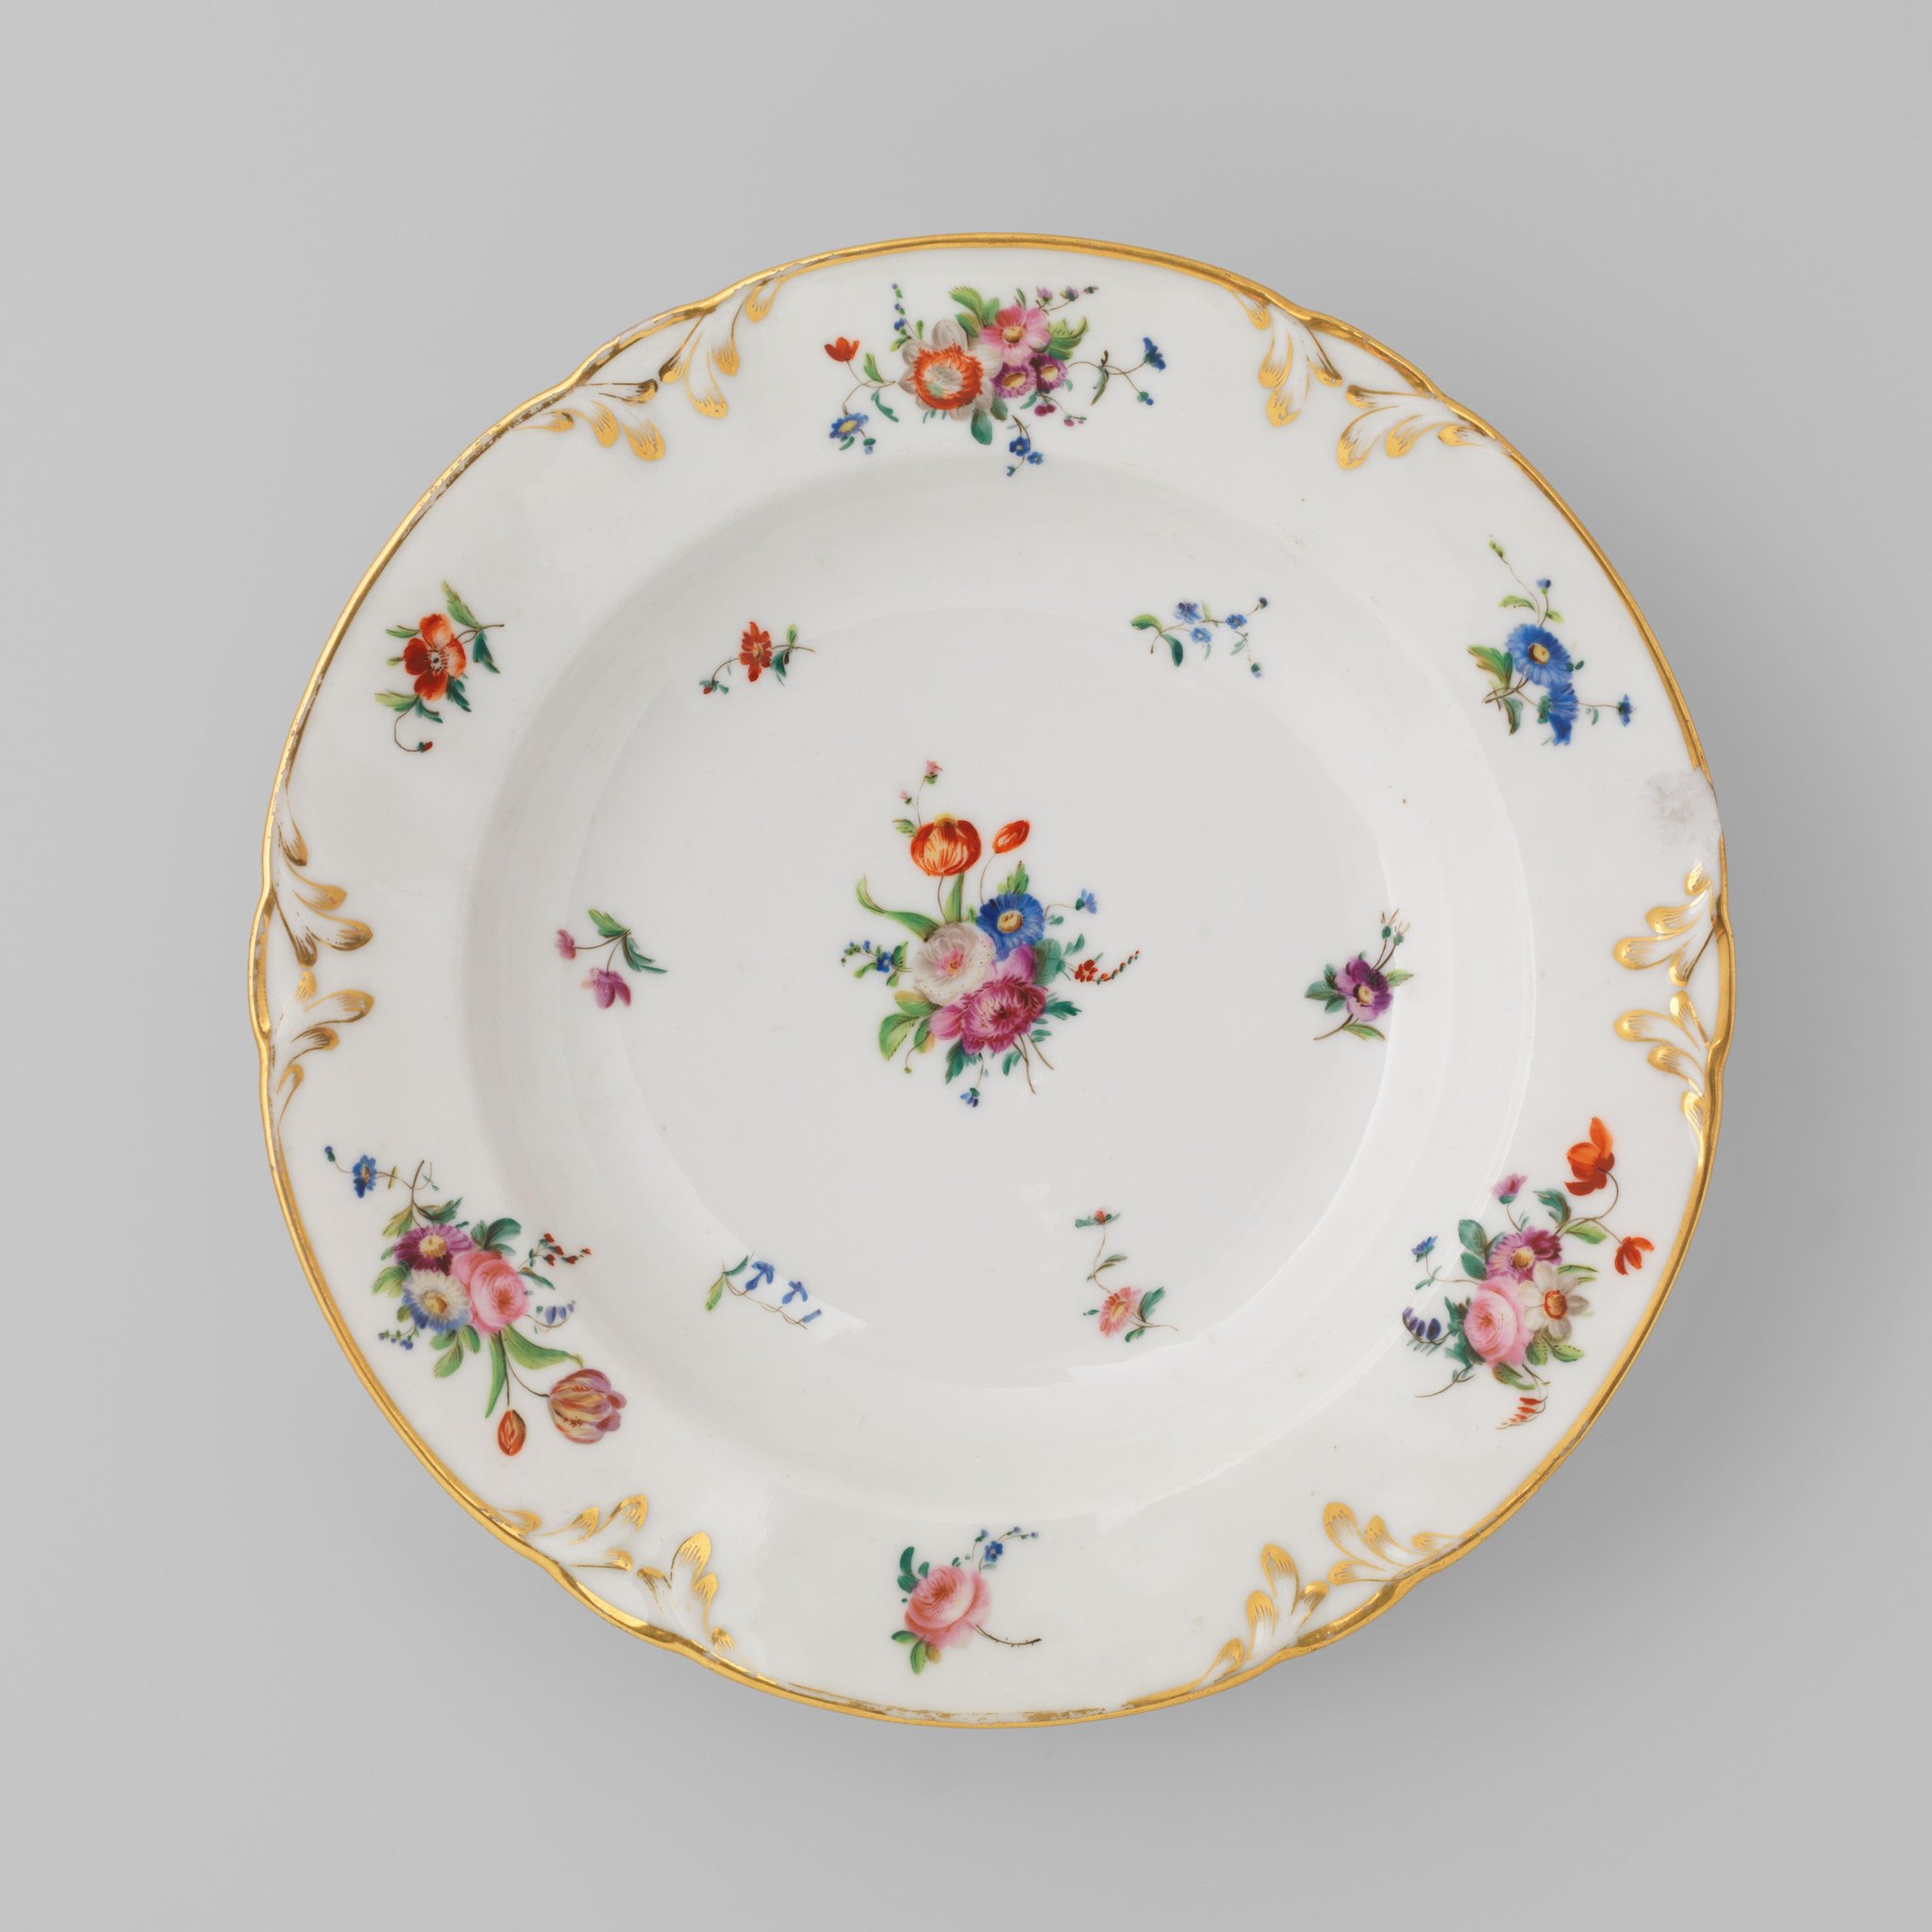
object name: service set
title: Plate with bouquets and flower sprays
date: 1839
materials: glaze, gold, paint, porcelain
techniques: firing, forming, gilding, turning, vitrification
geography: paris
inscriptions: mark: ‘DENUELLE/ Boulevard St. Denis 18/ à Paris’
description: Diep bord van porselein met een gelobde rand, beschilderd op het glazuur in blauw, rood, roze, groen, geel, paars, zwart en goud. Op het plat boeketten van verschillende bloemen en strooibloemen. Vanuit de gelobde, gouden rand, gemodelleerde bladranken in reliëf, aangezet met goud. Hiertussen boeketten. Drie proenen op de onderzijde. Gemerkt op de onderzijde met 'DENUELLE/ Boulevard St. Denis 18/ à Paris'.